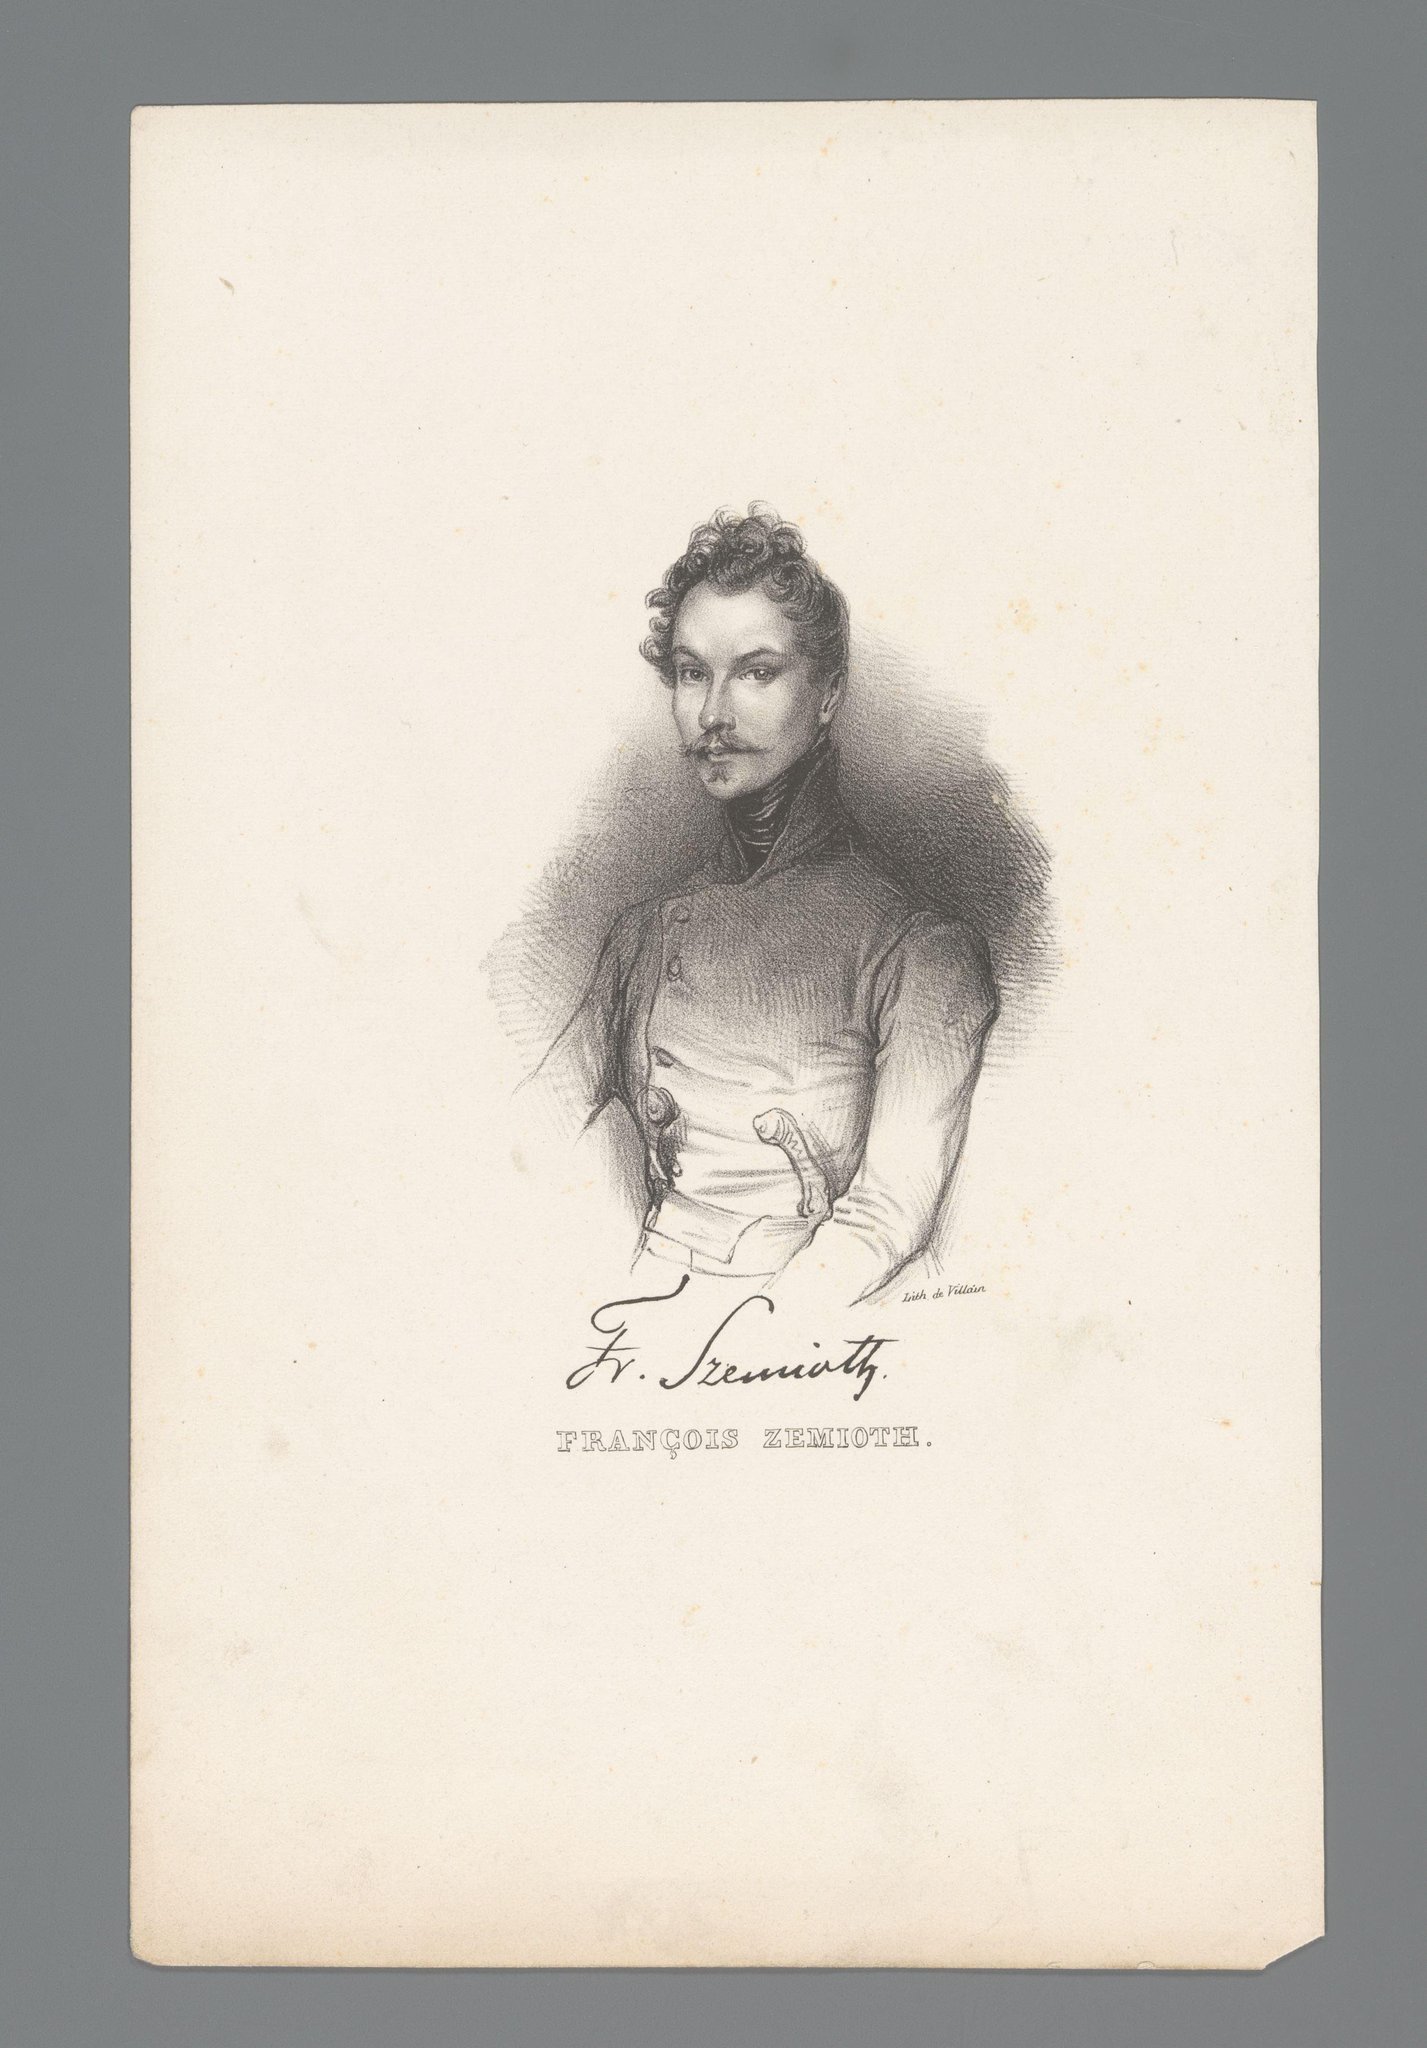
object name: book illustration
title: Portret van Franciszek Szemioth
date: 1832-1839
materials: paper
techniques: lithograph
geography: paris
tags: historical persons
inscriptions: collector's mark: Lugt 2228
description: Prent uit: Straszewicz., Joseph. Les polonais et les polonaises de la révolution du 29 novembre 1830, ou Portraits des personnes qui ont figuré dans la dernière guerre de l'indépendance polonaise, avec les fac-simile de leur signature, lithographiés sur dessins originaux, par les artistes les plus distingués: MM. Grévedon, Maurin, Vigneron, Belliard, Devéria, Bazin, Desmadryl, Lecler, Desmaisons, Rutowski, officier polonais, etc,. etc., accompagnés d'une biographie pour chaque portrait. Parijs: Catherine-Anaïs Pinard, 1832. Of uit: Straszewicz., Joseph. Les polonais et les polonaises de la révolution du 29 novembre 1830. Biographie des personnes qui ont figuré dans la dernière guerre de l'indépendance polonaise, avec les fac-simile de leur signature, ornée de 30 portraits lithographiés sur dessins originaux, par les artistes les plus distingués: MM. Grévedon, Maurin, Vigneron, Belliard, Devéria, Bazin, Desmadryl, Lecler, etc., etc.. Parijs: s.n., 1839.